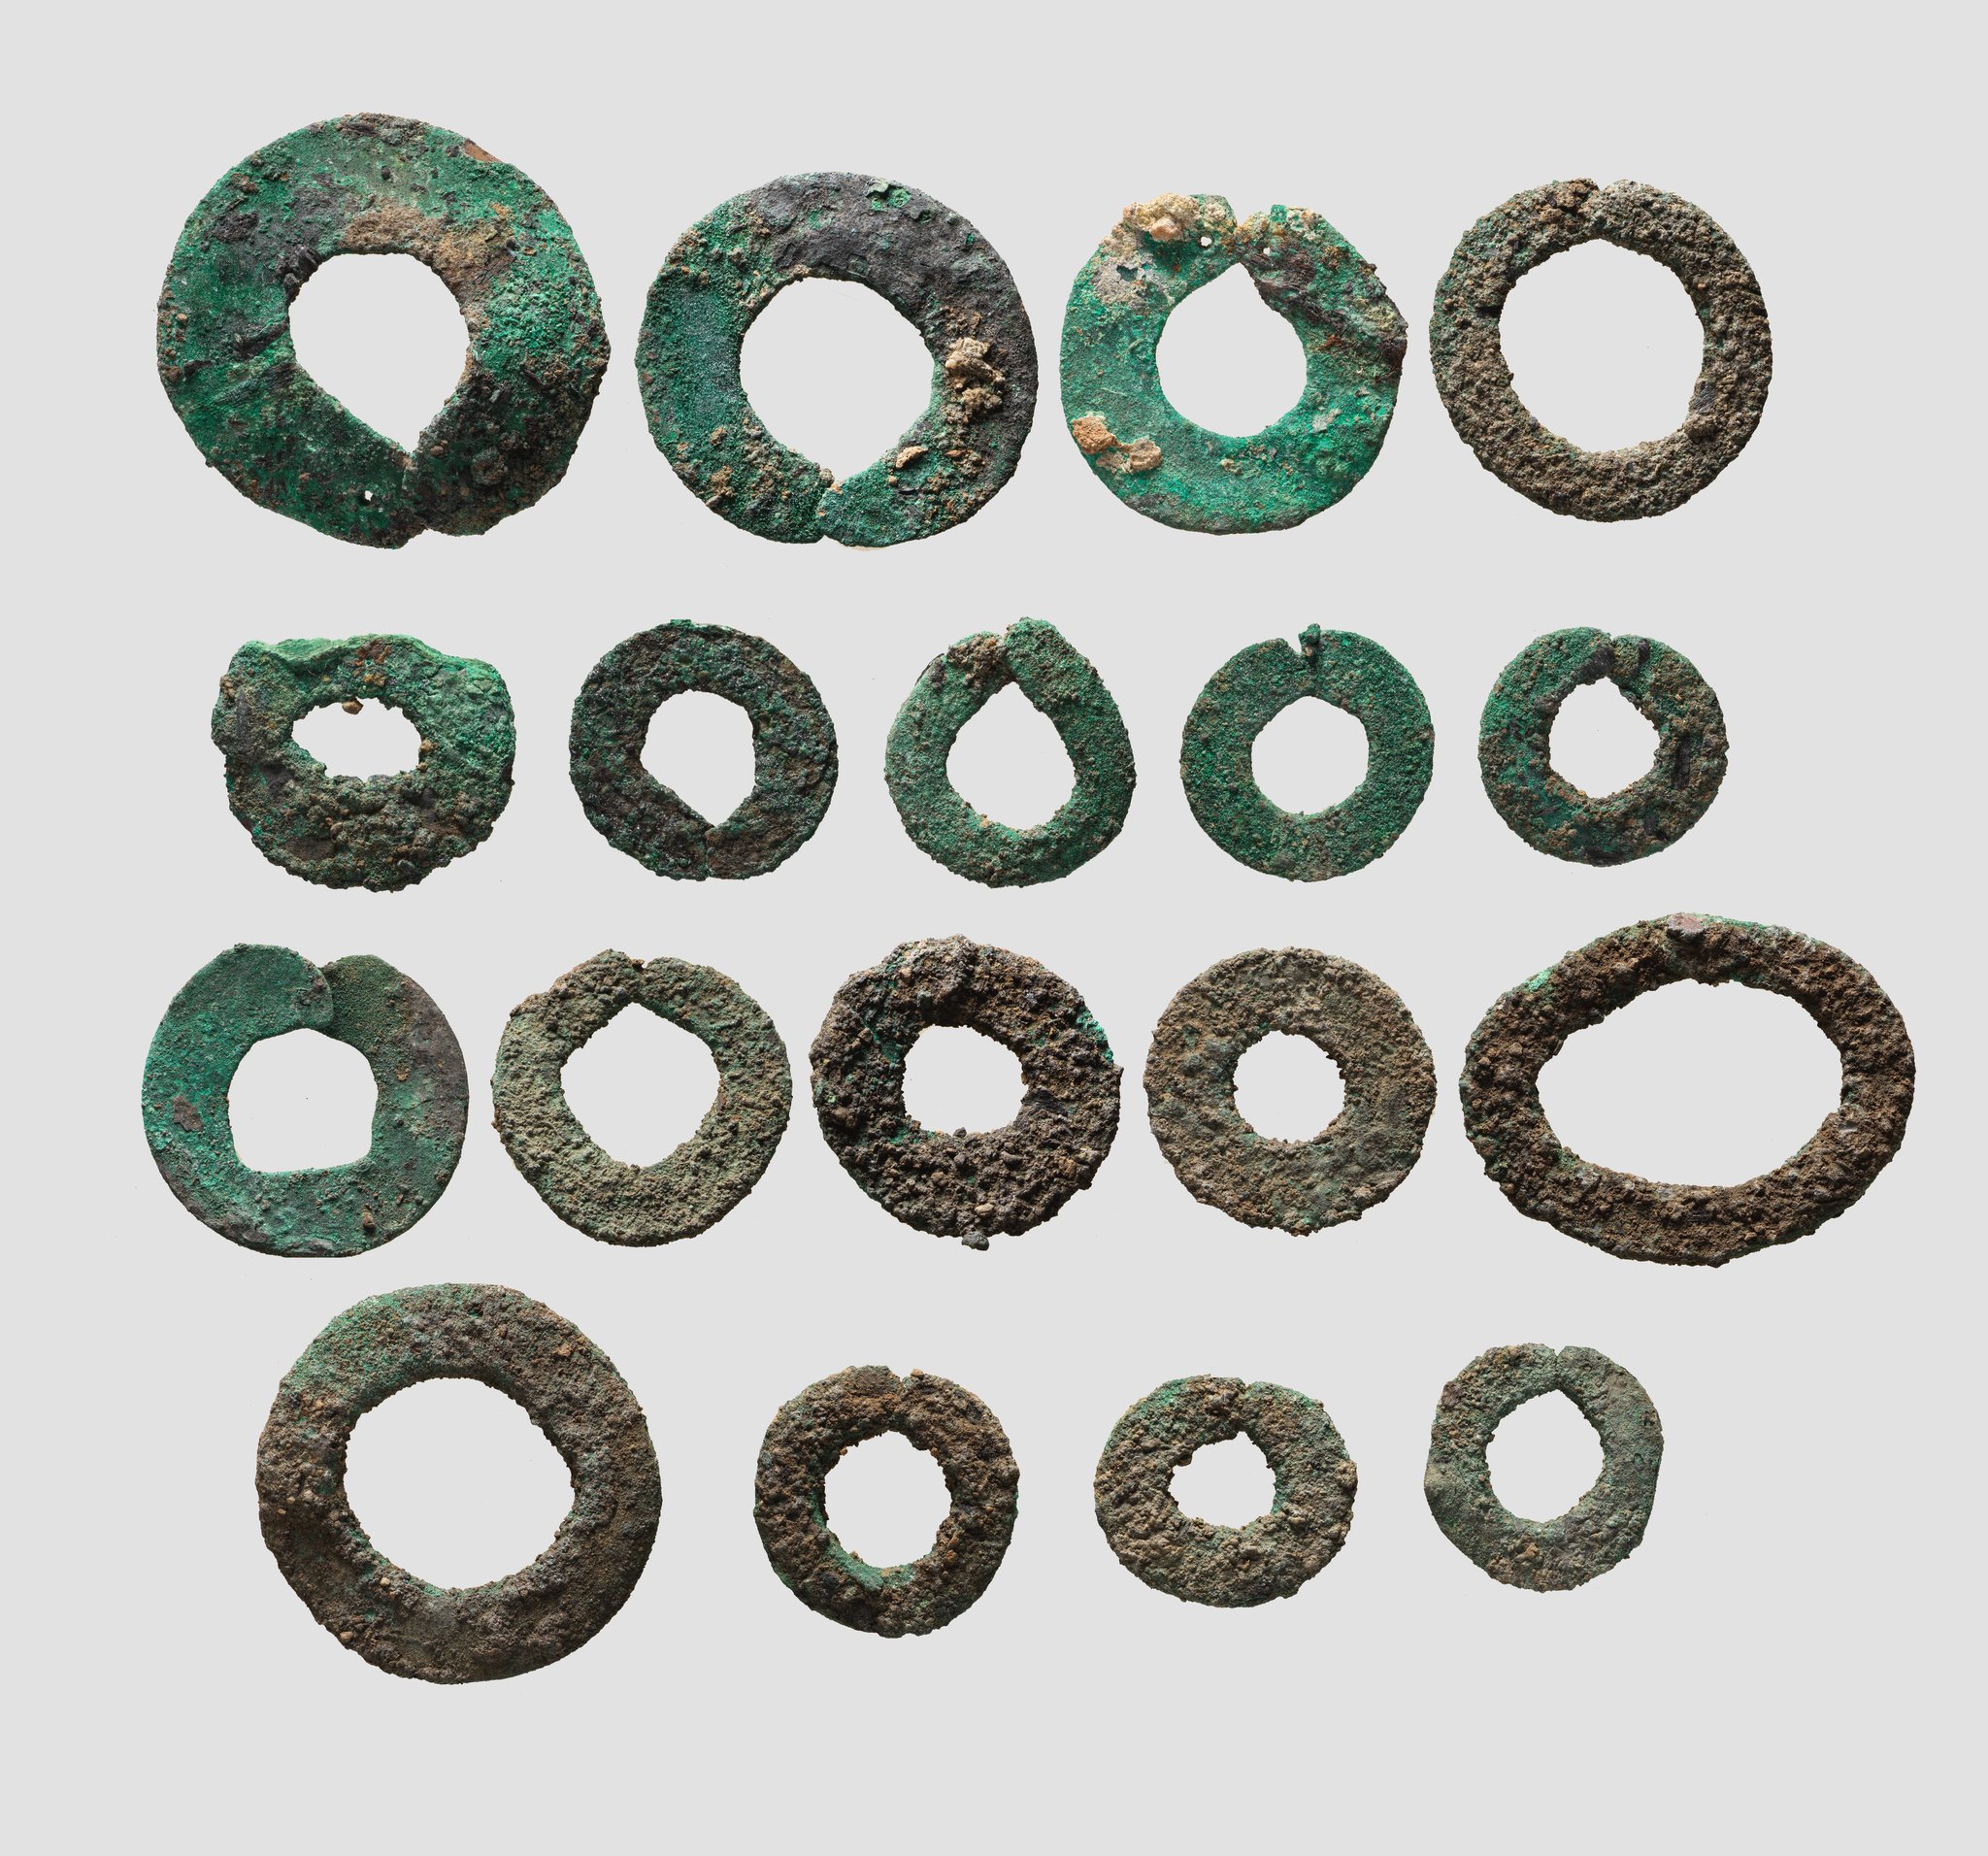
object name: ring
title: Rings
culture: iranian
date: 900-801 BCE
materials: bronze, copper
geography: iran